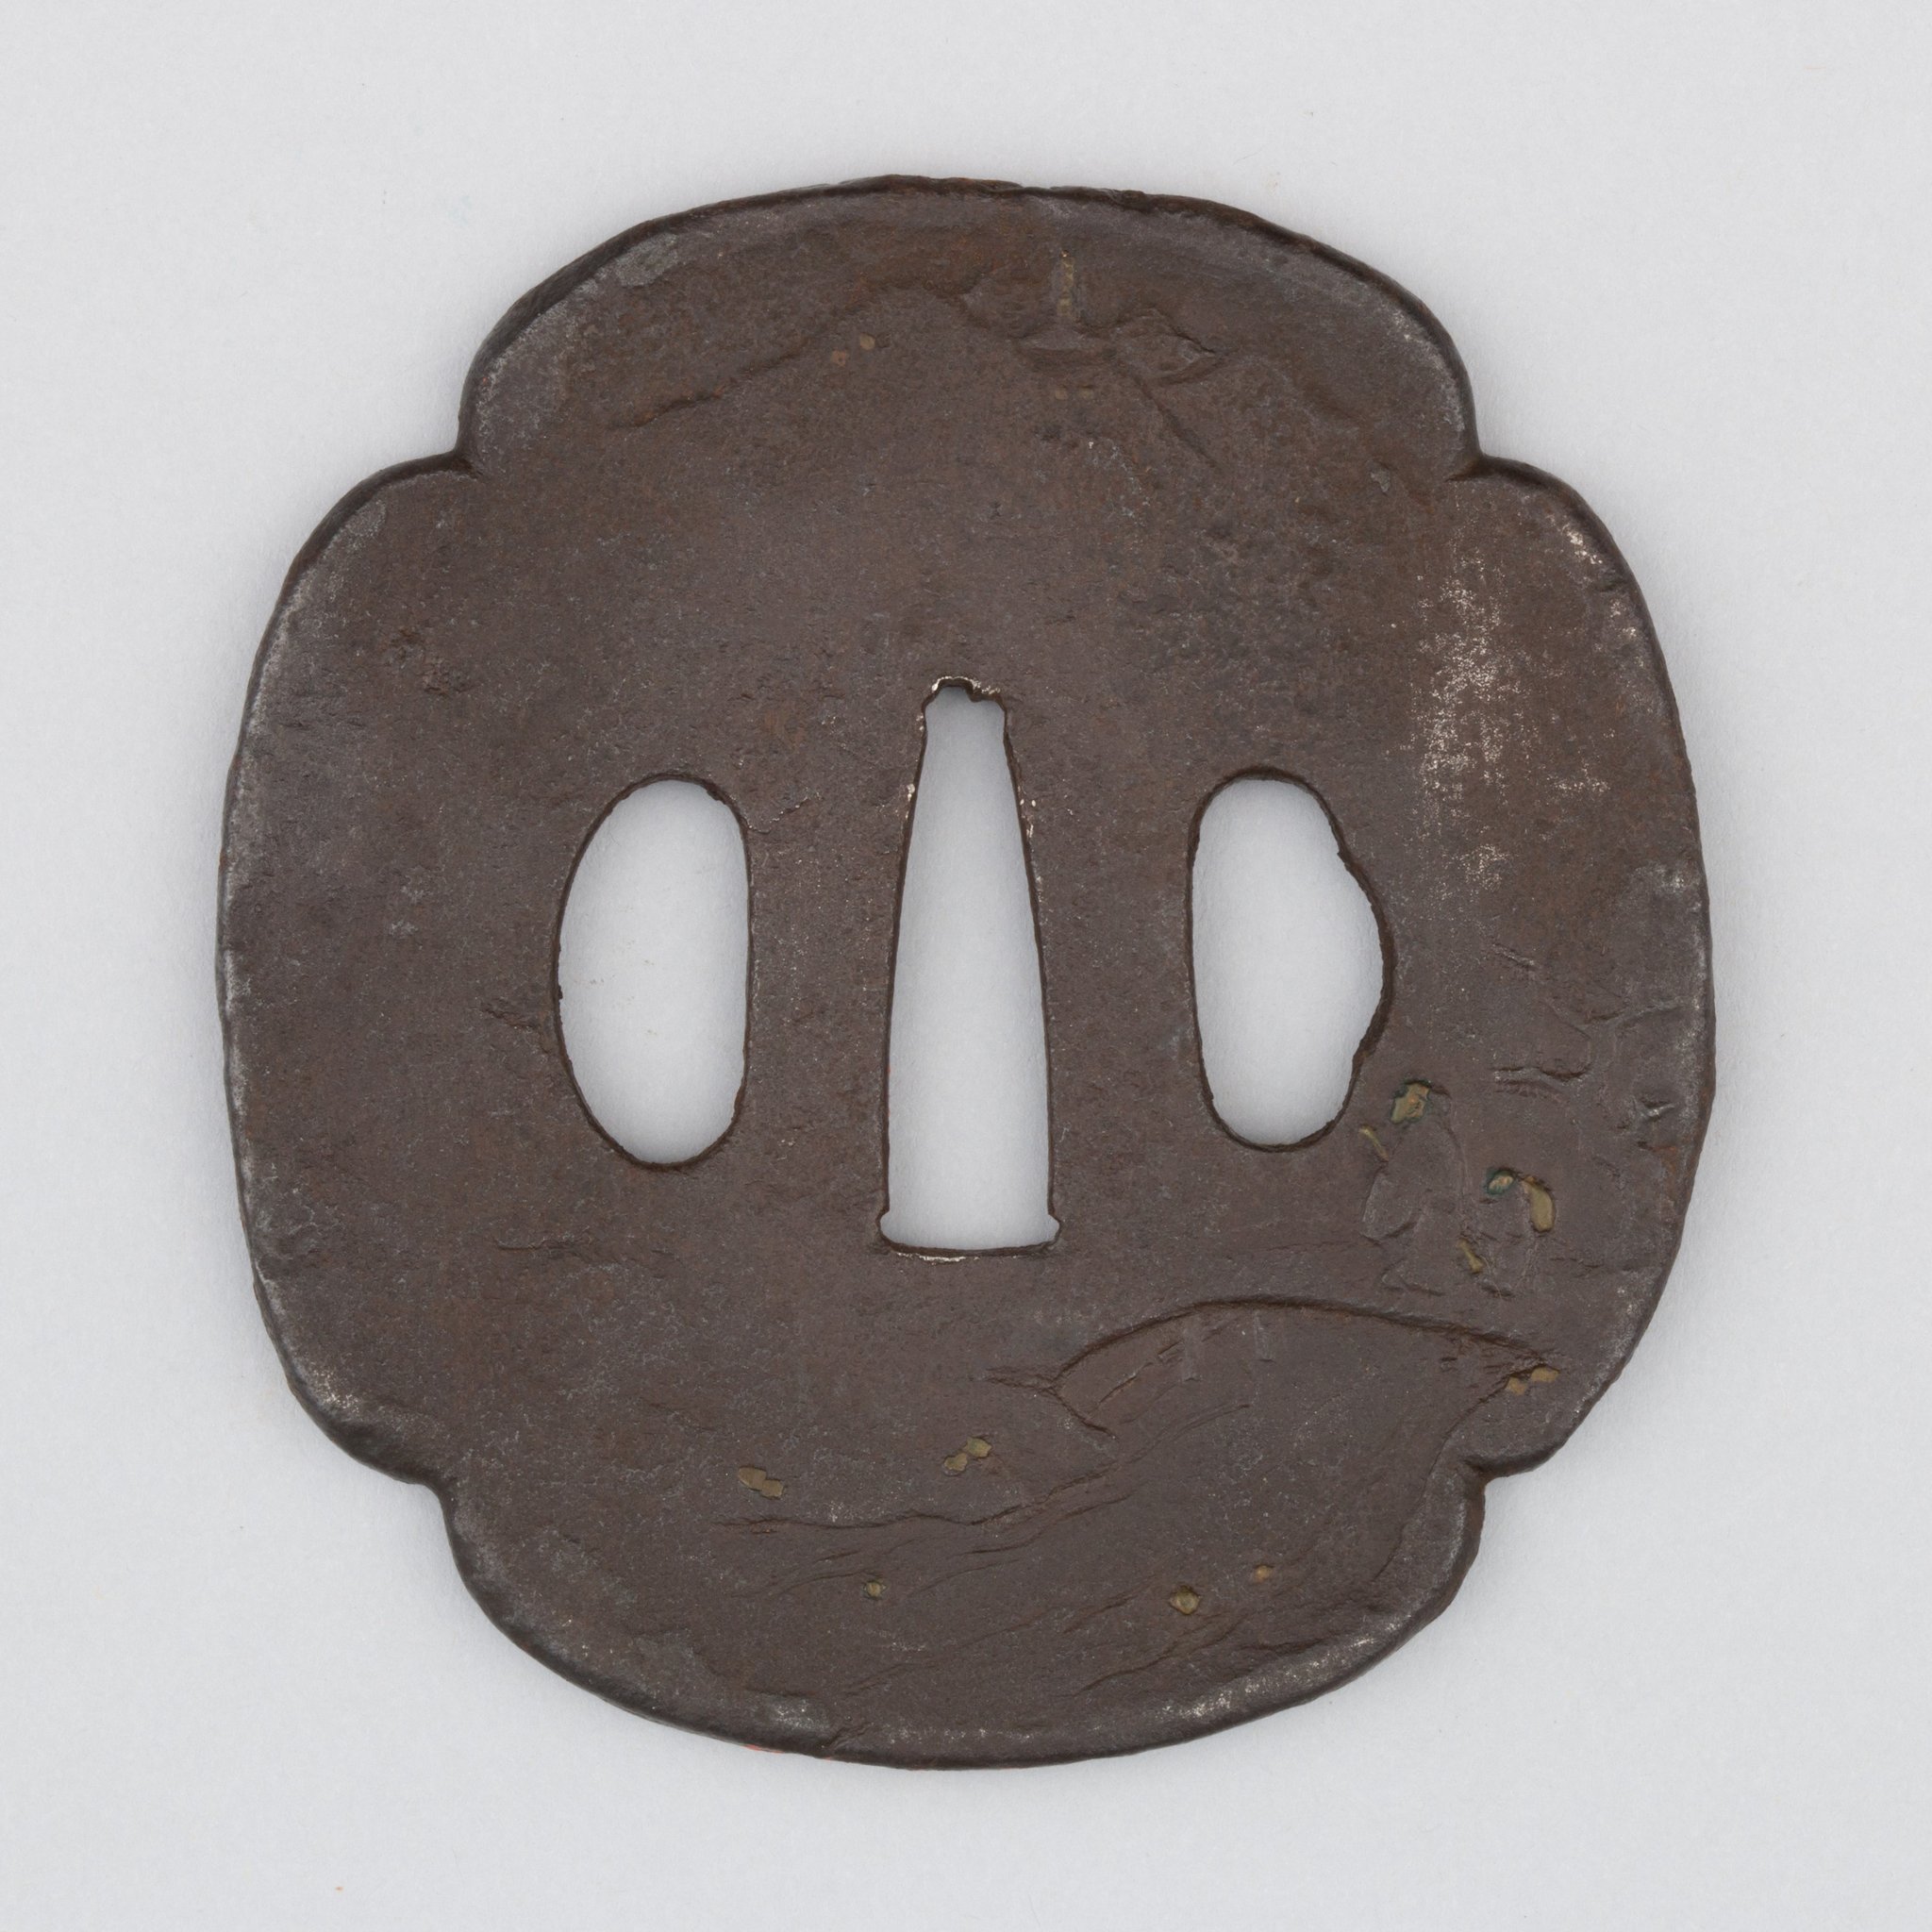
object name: sword guard tsuba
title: Sword Guard (Tsuba)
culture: japanese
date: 1701-1800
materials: iron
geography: japan